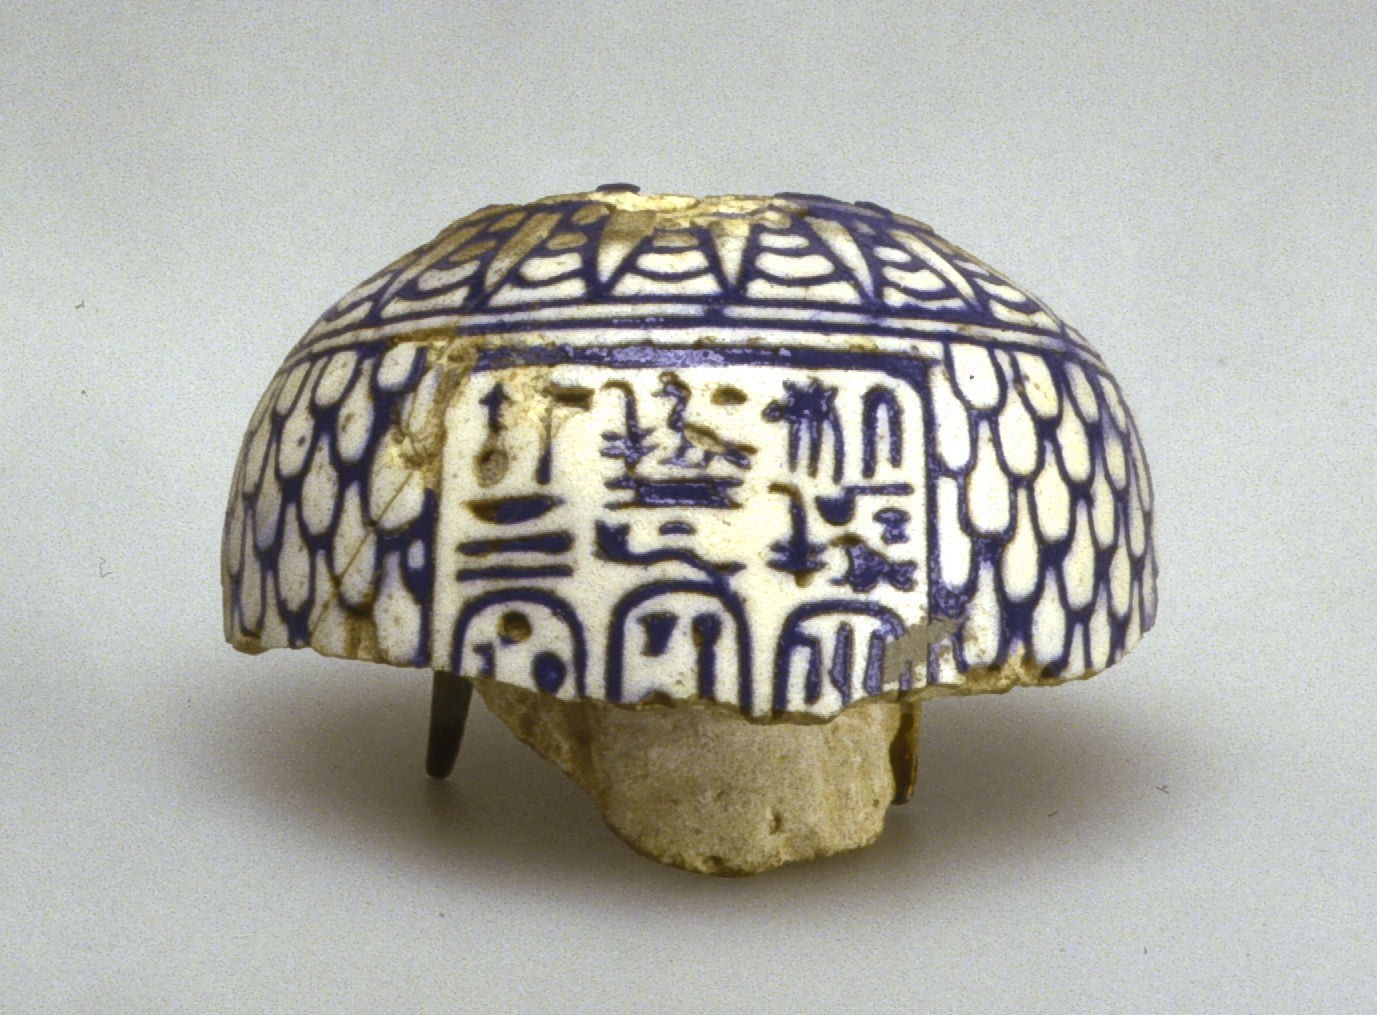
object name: vase fragment, amenhotep iii, tiye, hennetaneb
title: Vase fragment with the names of Amenhotep III, Tiye, and Hennetaneb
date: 1390-1352 BCE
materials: faience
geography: egypt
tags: hieroglyphs